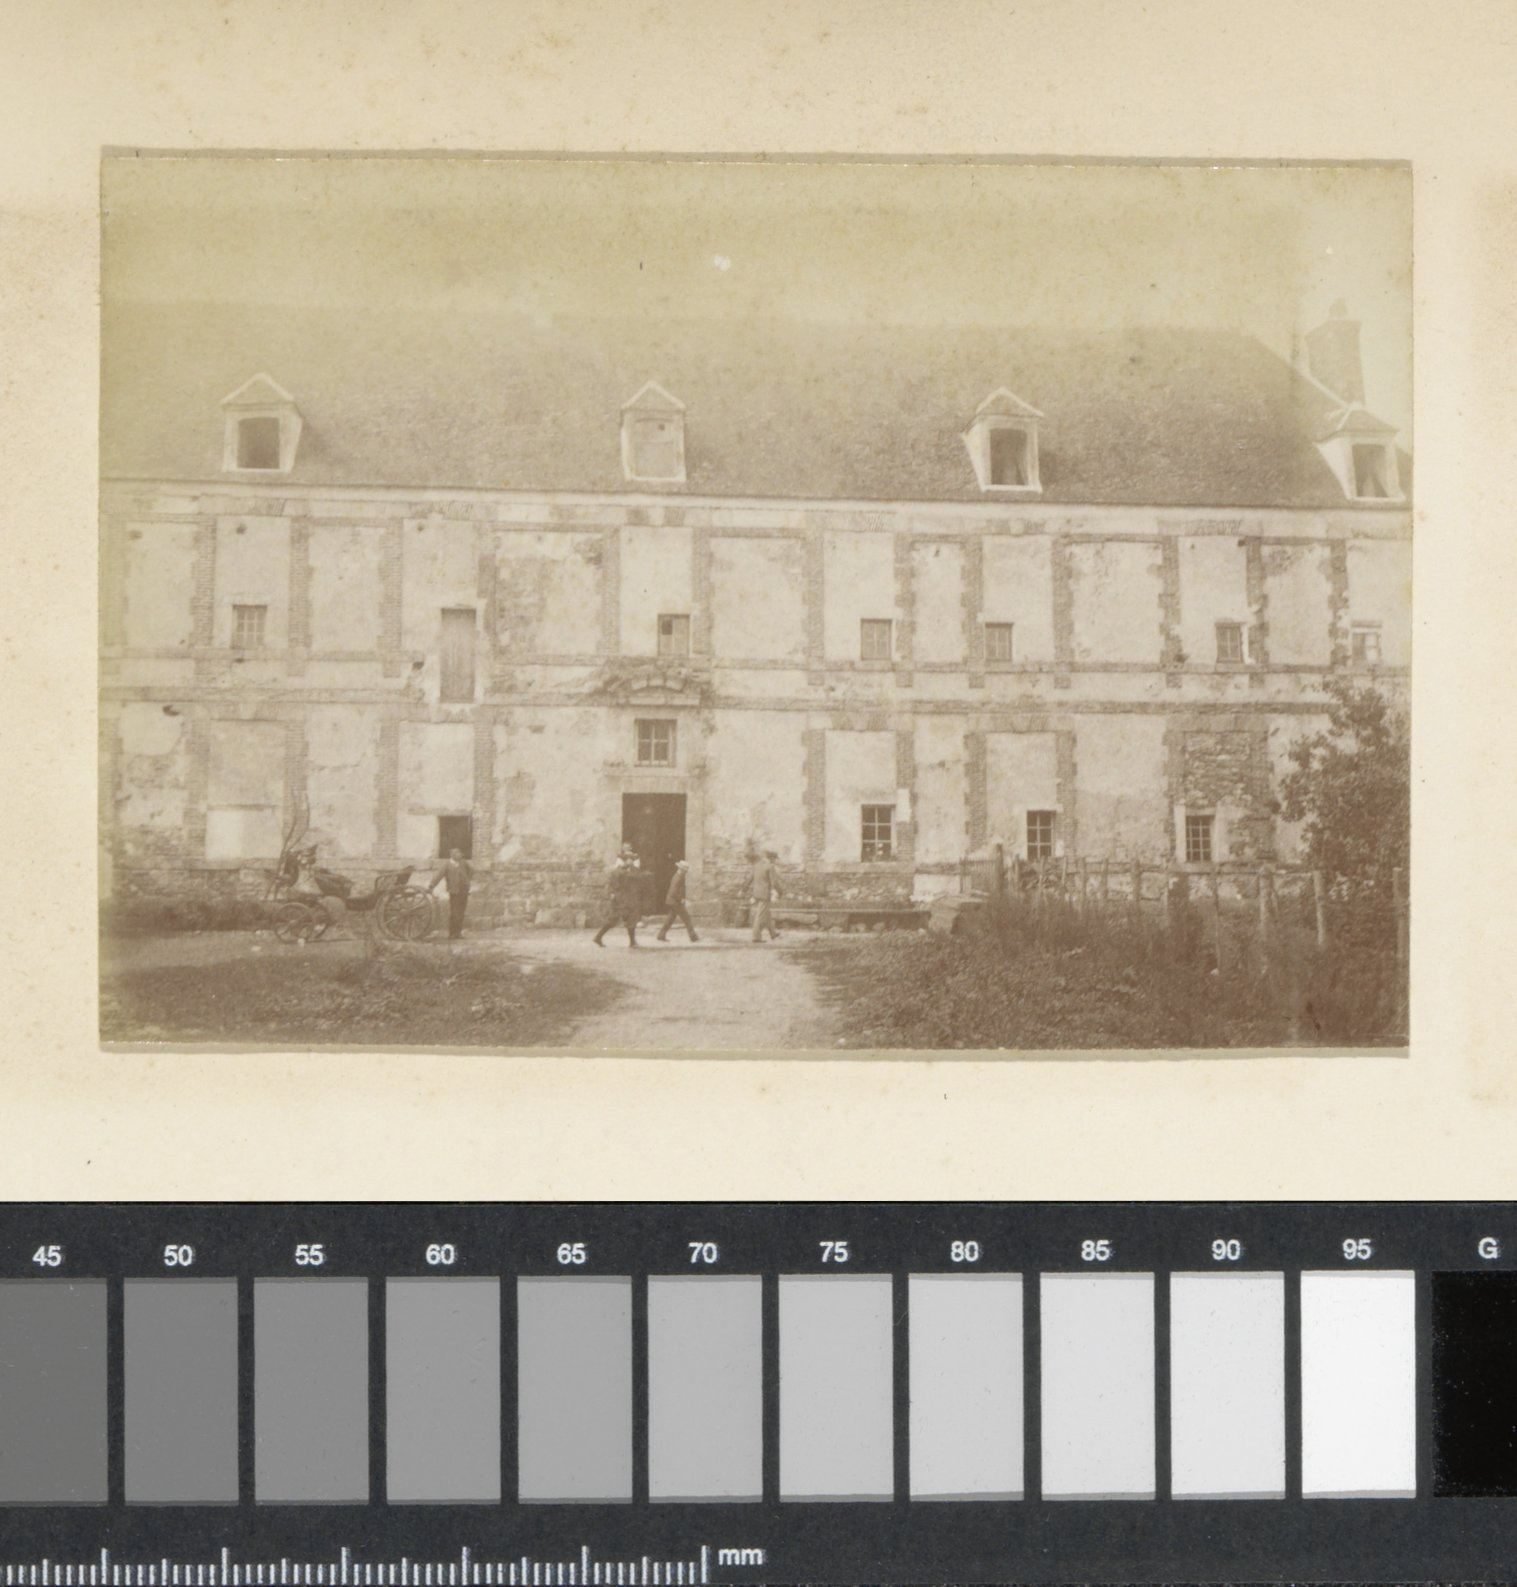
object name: photograph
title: Facade van een landhuis met dichtgemetselde ramen in Frankrijk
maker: Anonymous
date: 1900-1910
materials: paper, photographic support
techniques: albumen print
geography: france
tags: rural housing, e.g. country-house, villa, cottage, façade (of house or building), france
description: Onderdeel van Fotoalbum van een Franse amateurfotograaf met opnames van een familie, distilleerderij Delizy & Doistau Fils, het leger en bezienswaardigheden in Frankrijk.